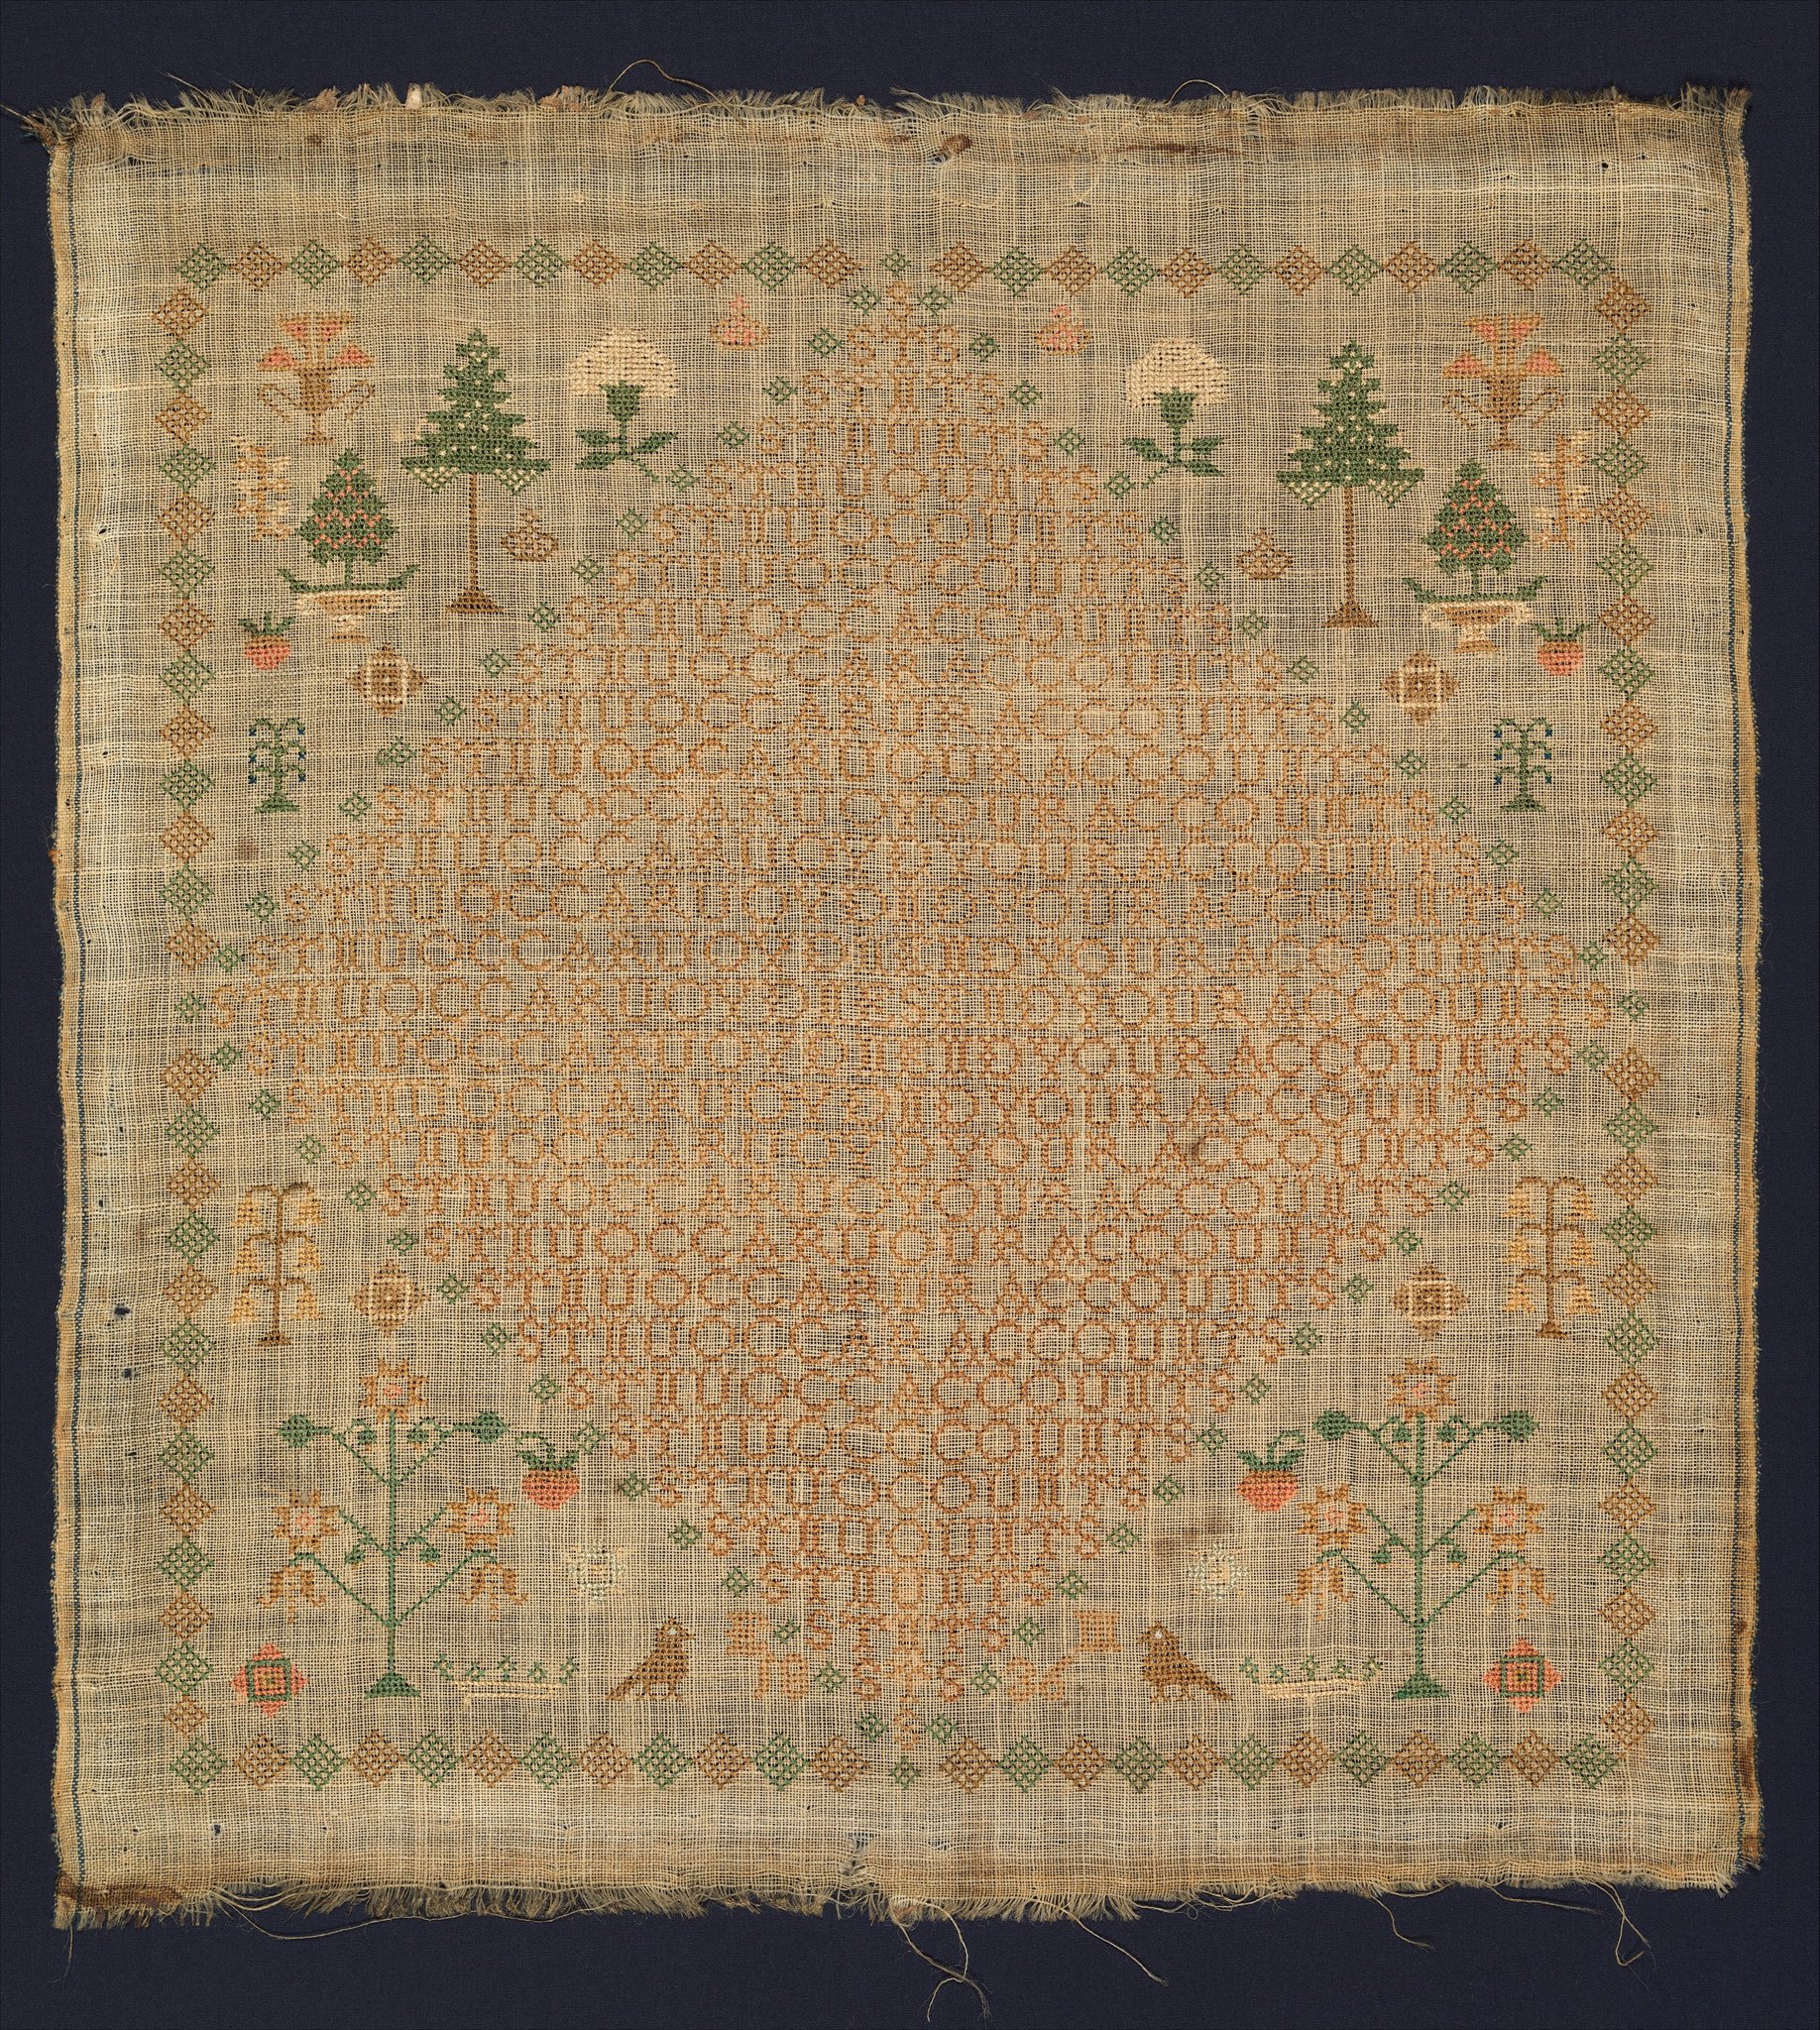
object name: sampler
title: Sampler with an acrostic reading "Send Your Accounts"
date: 1836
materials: silk, wool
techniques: embroidery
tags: birds,trees